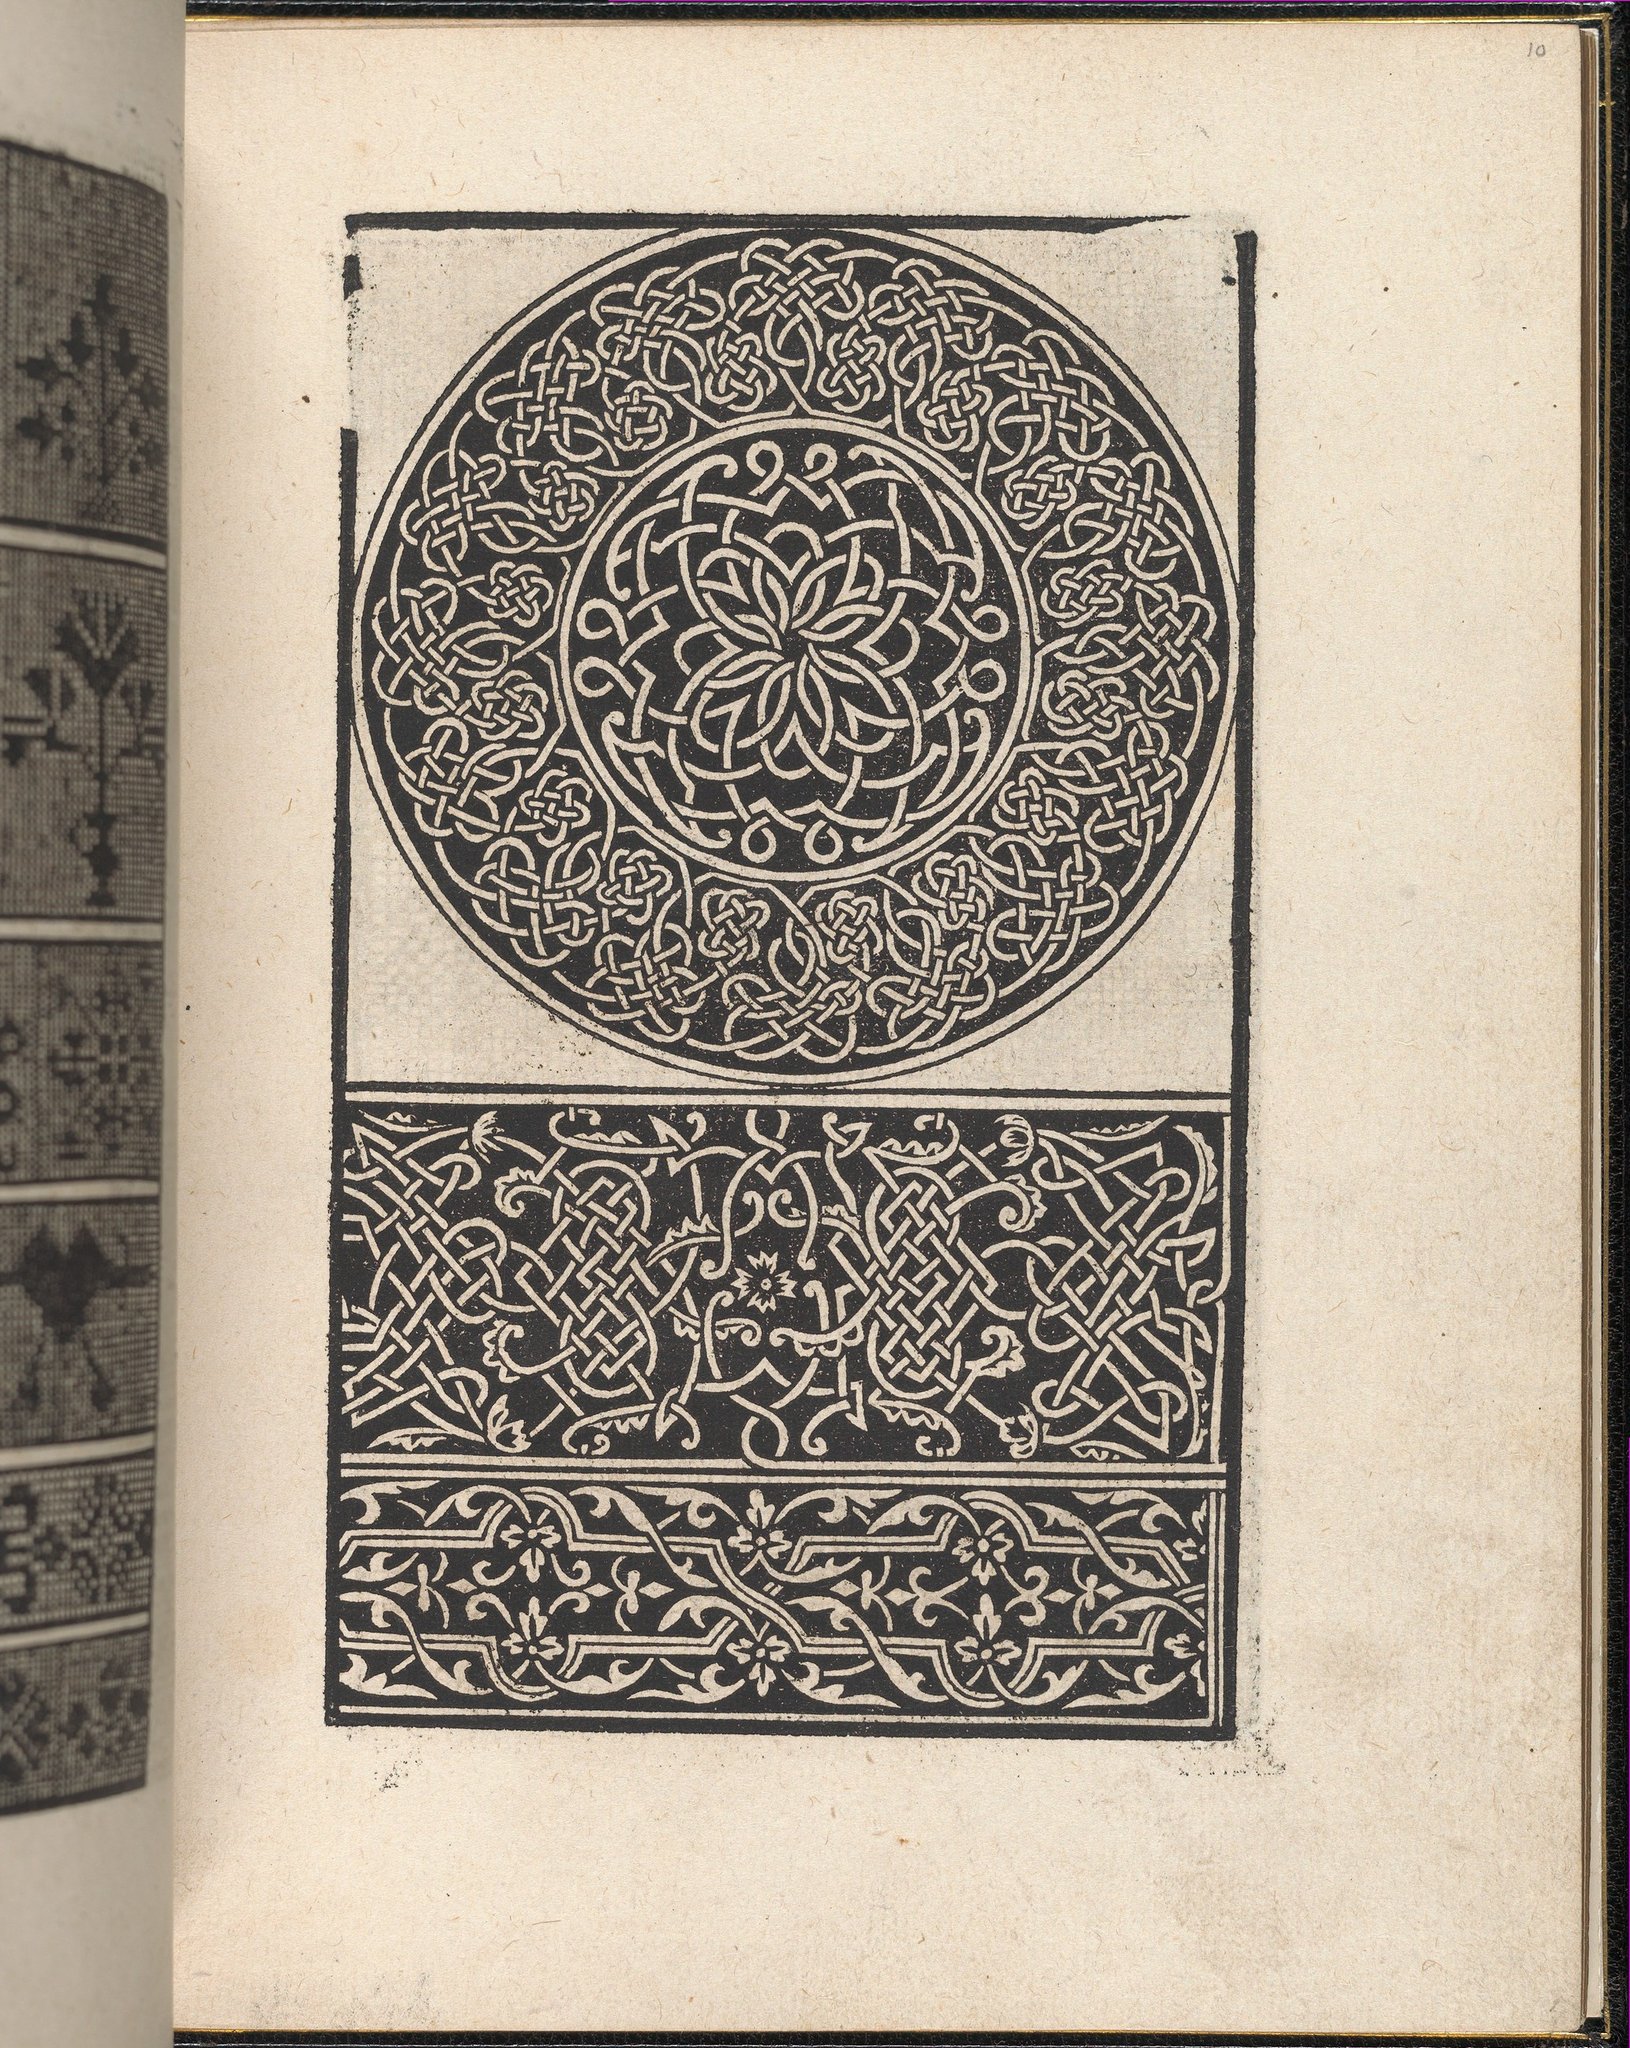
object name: book print ornament architecture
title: Page from Ein new kunstlich Modelbuch...(Page 10r)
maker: peter quentel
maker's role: publisher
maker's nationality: german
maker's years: 1500-1550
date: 1544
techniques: woodcut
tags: ornament